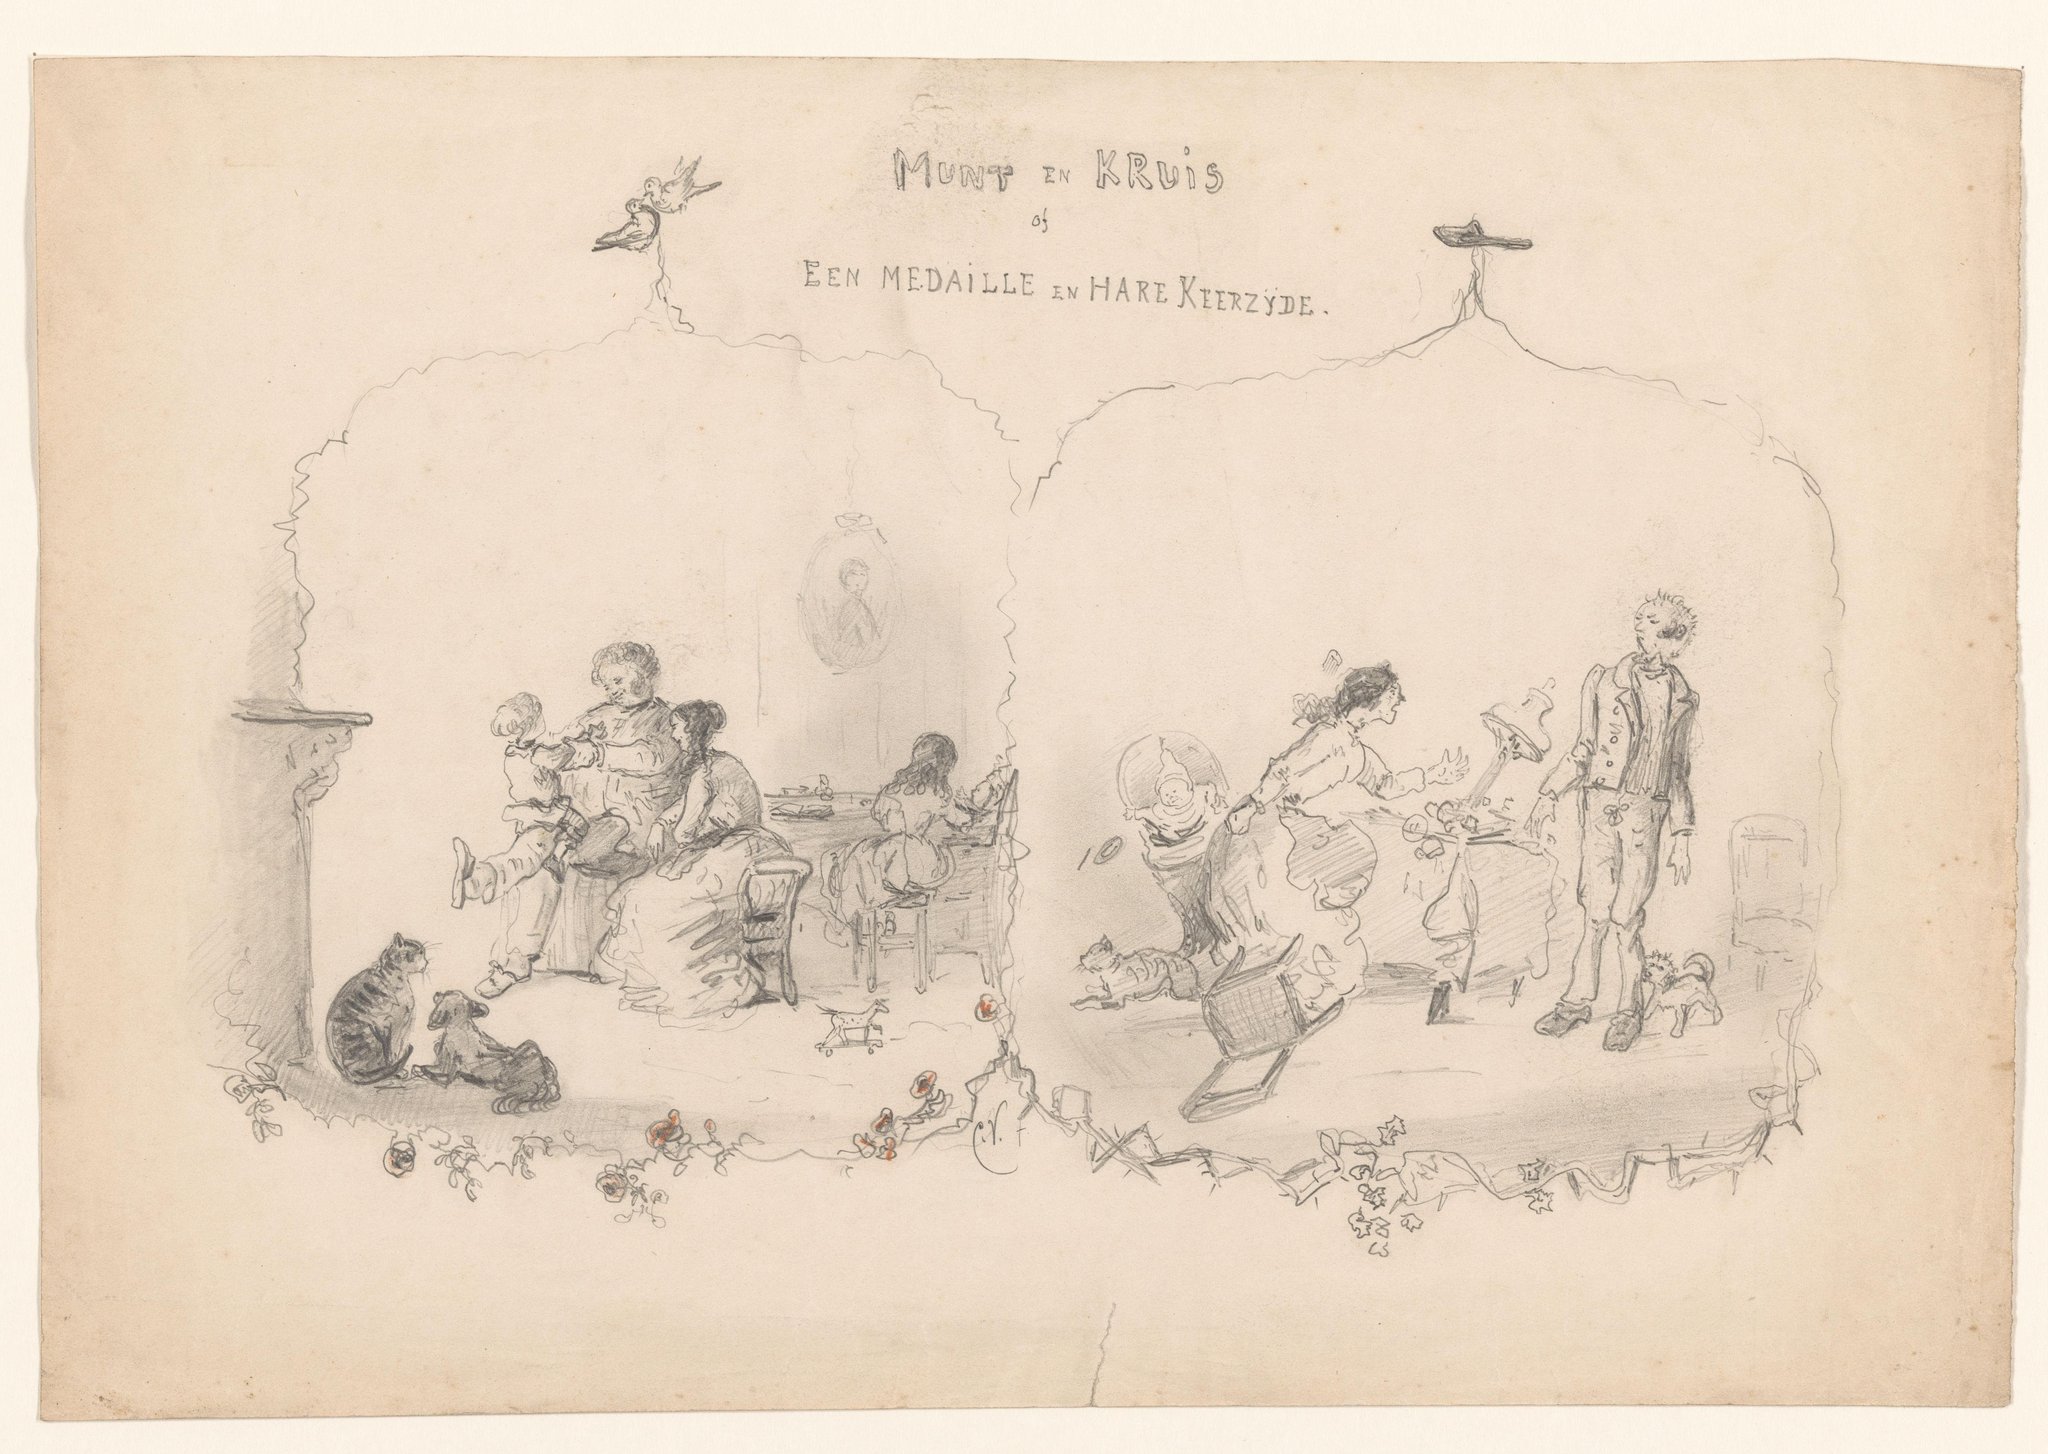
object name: drawing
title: Munt en Kruis of Een Medaille en Hare Keerzijde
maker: carel vosmaer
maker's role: draughtsman, print maker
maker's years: 1826-1888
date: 1836-1888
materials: chalk, paper, pencil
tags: man and wife quarrelling, 'marriage à la mode', happy marriage, satire on marriage